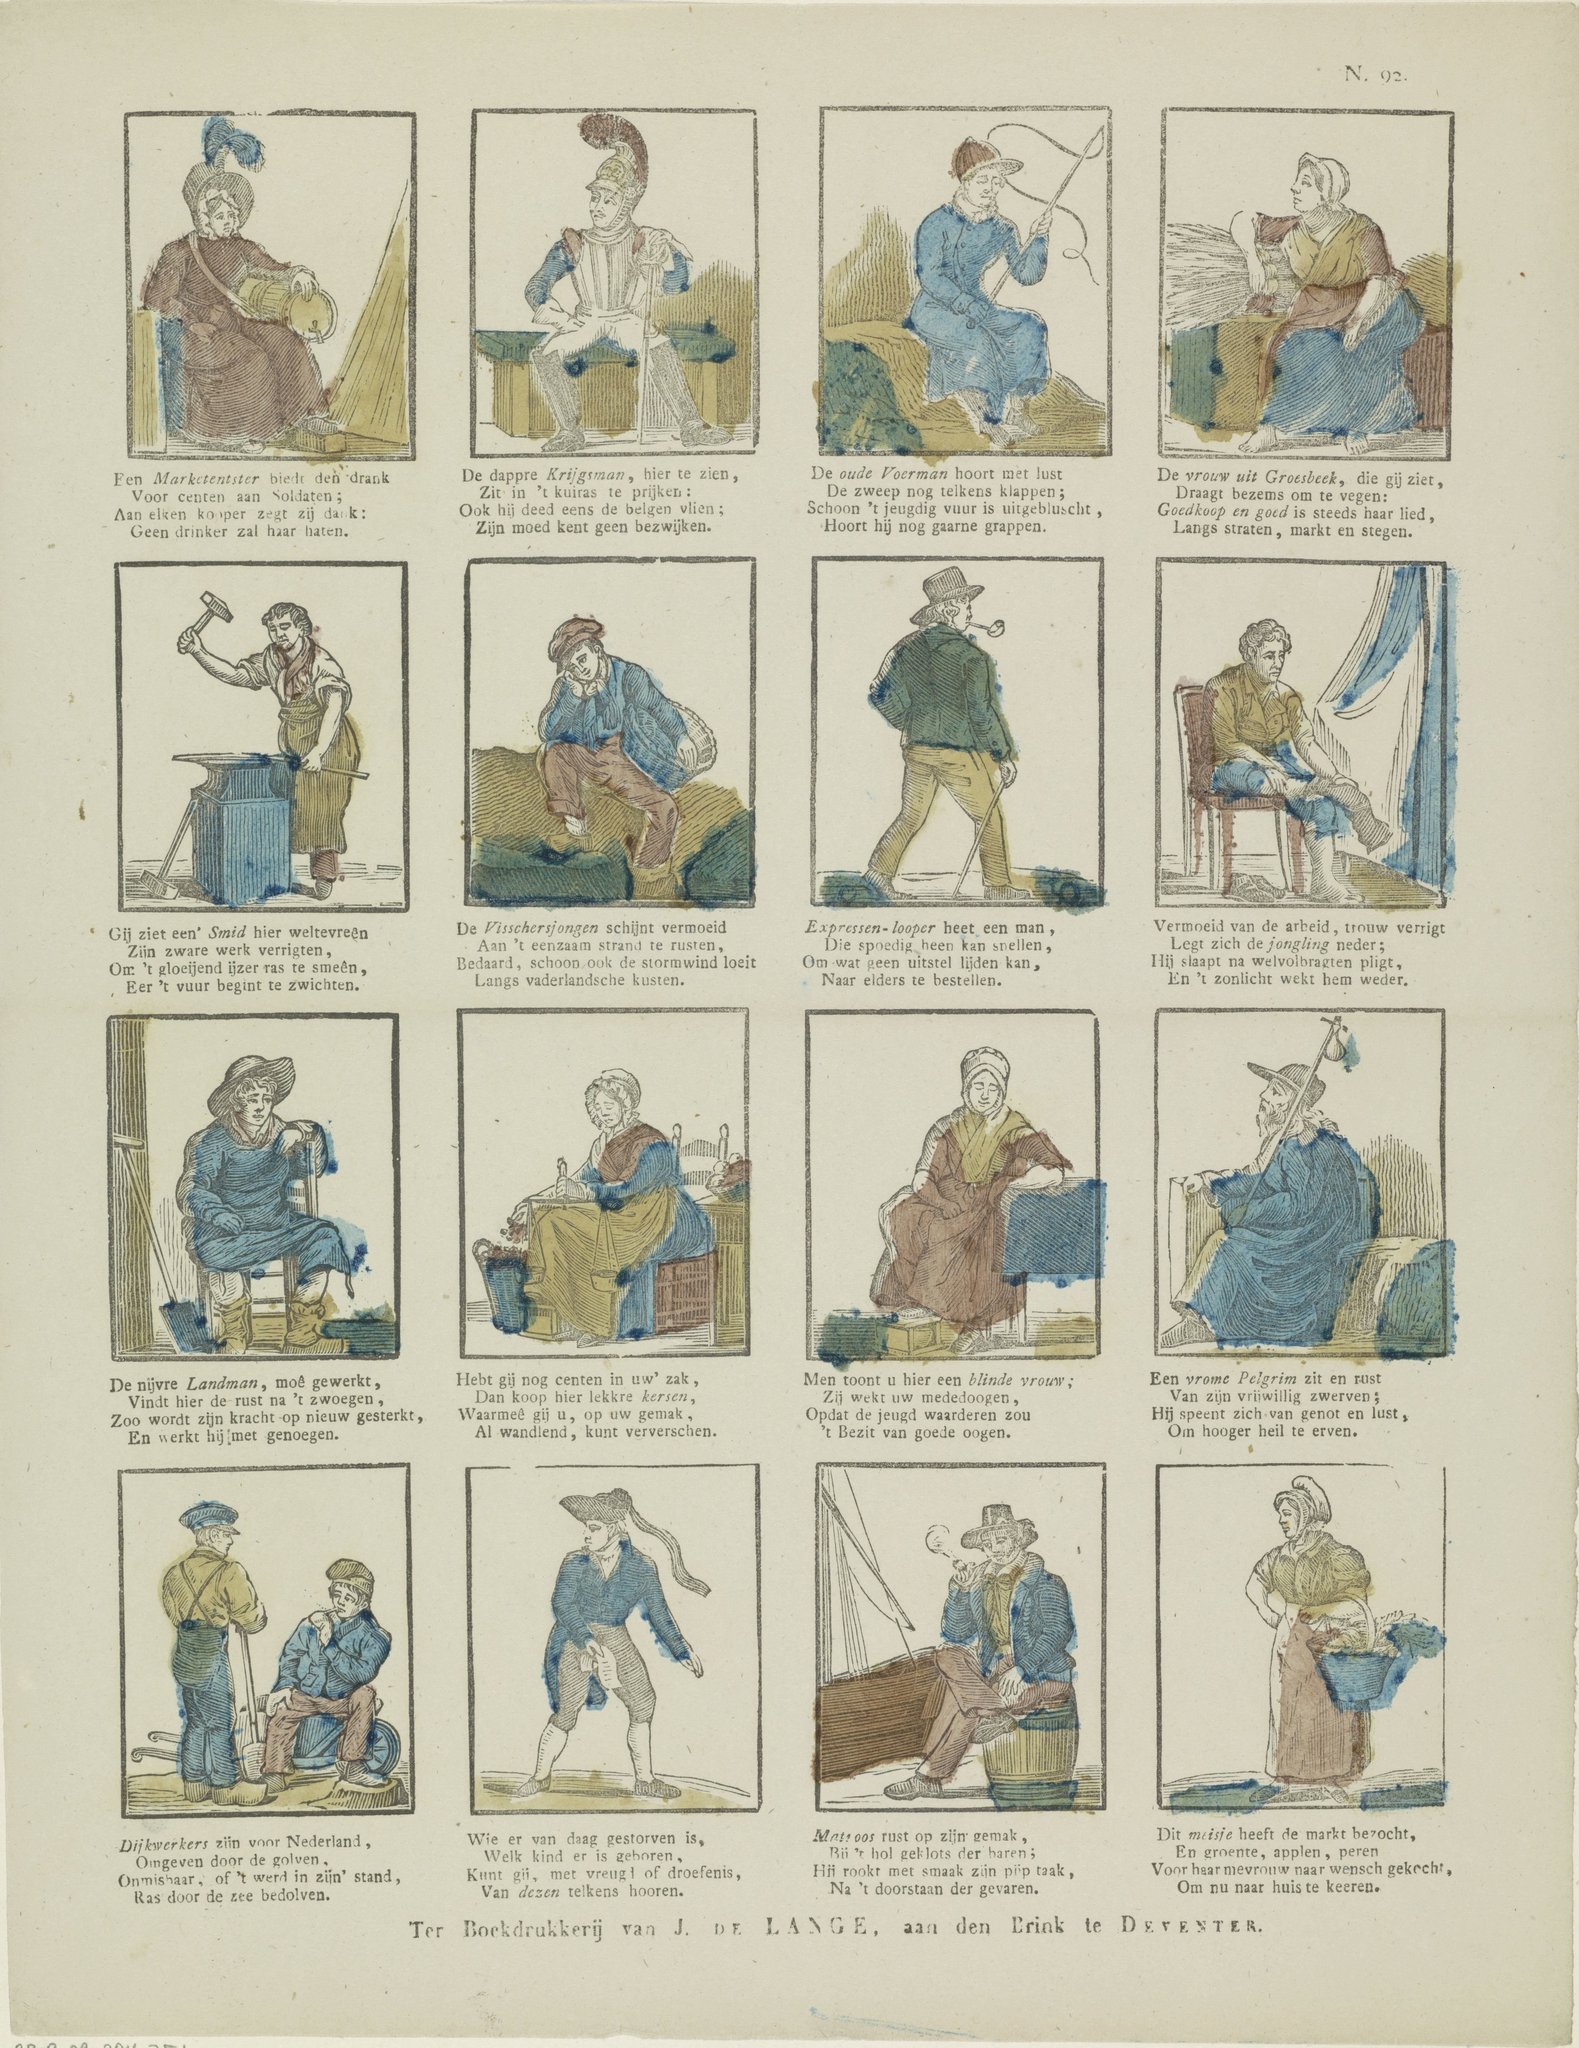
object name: print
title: Figuren, beroepen en ambachtslieden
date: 1822-1849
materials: paper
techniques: colour, letterpress printing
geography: netherlands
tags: craft-production, skilled handiwork, human types, working class, labourers, the soldier; the soldier's life, crafts and industries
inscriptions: collector's mark: Lugt 2760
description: Blad met 16 voorstellingen van figuren, beroepen en ambachtslieden. Onder elke afbeelding een vierregelig vers. Genummerd rechtsboven: N. 92.